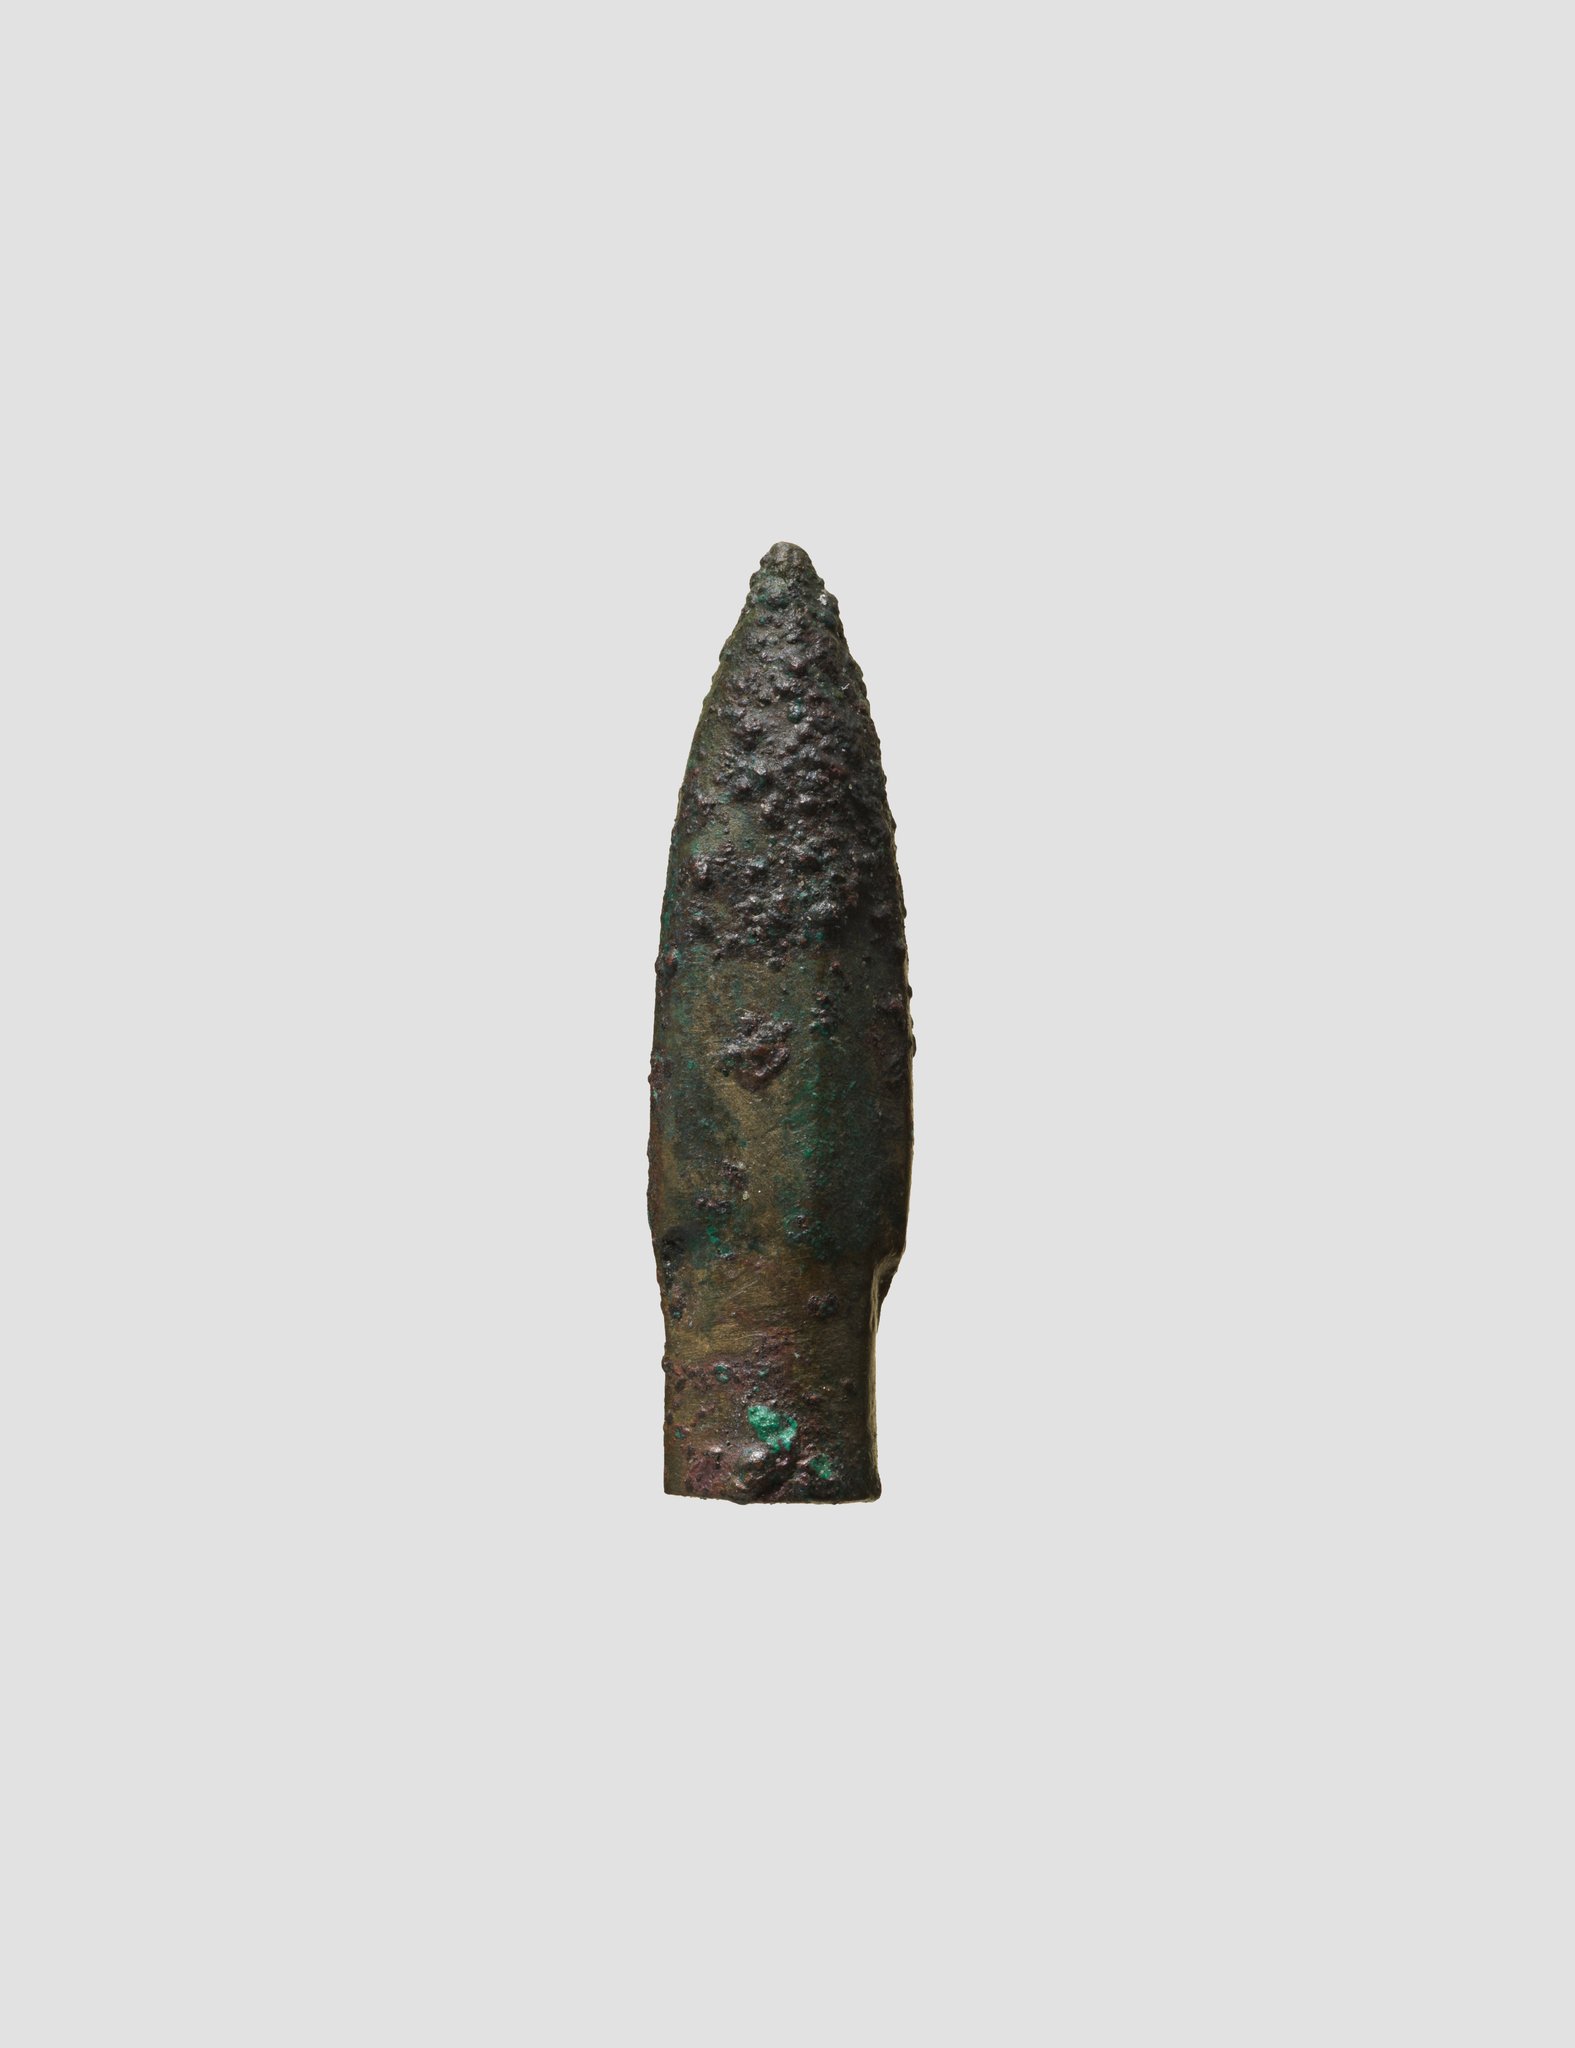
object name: arrowhead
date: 601-700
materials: bronze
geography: iran